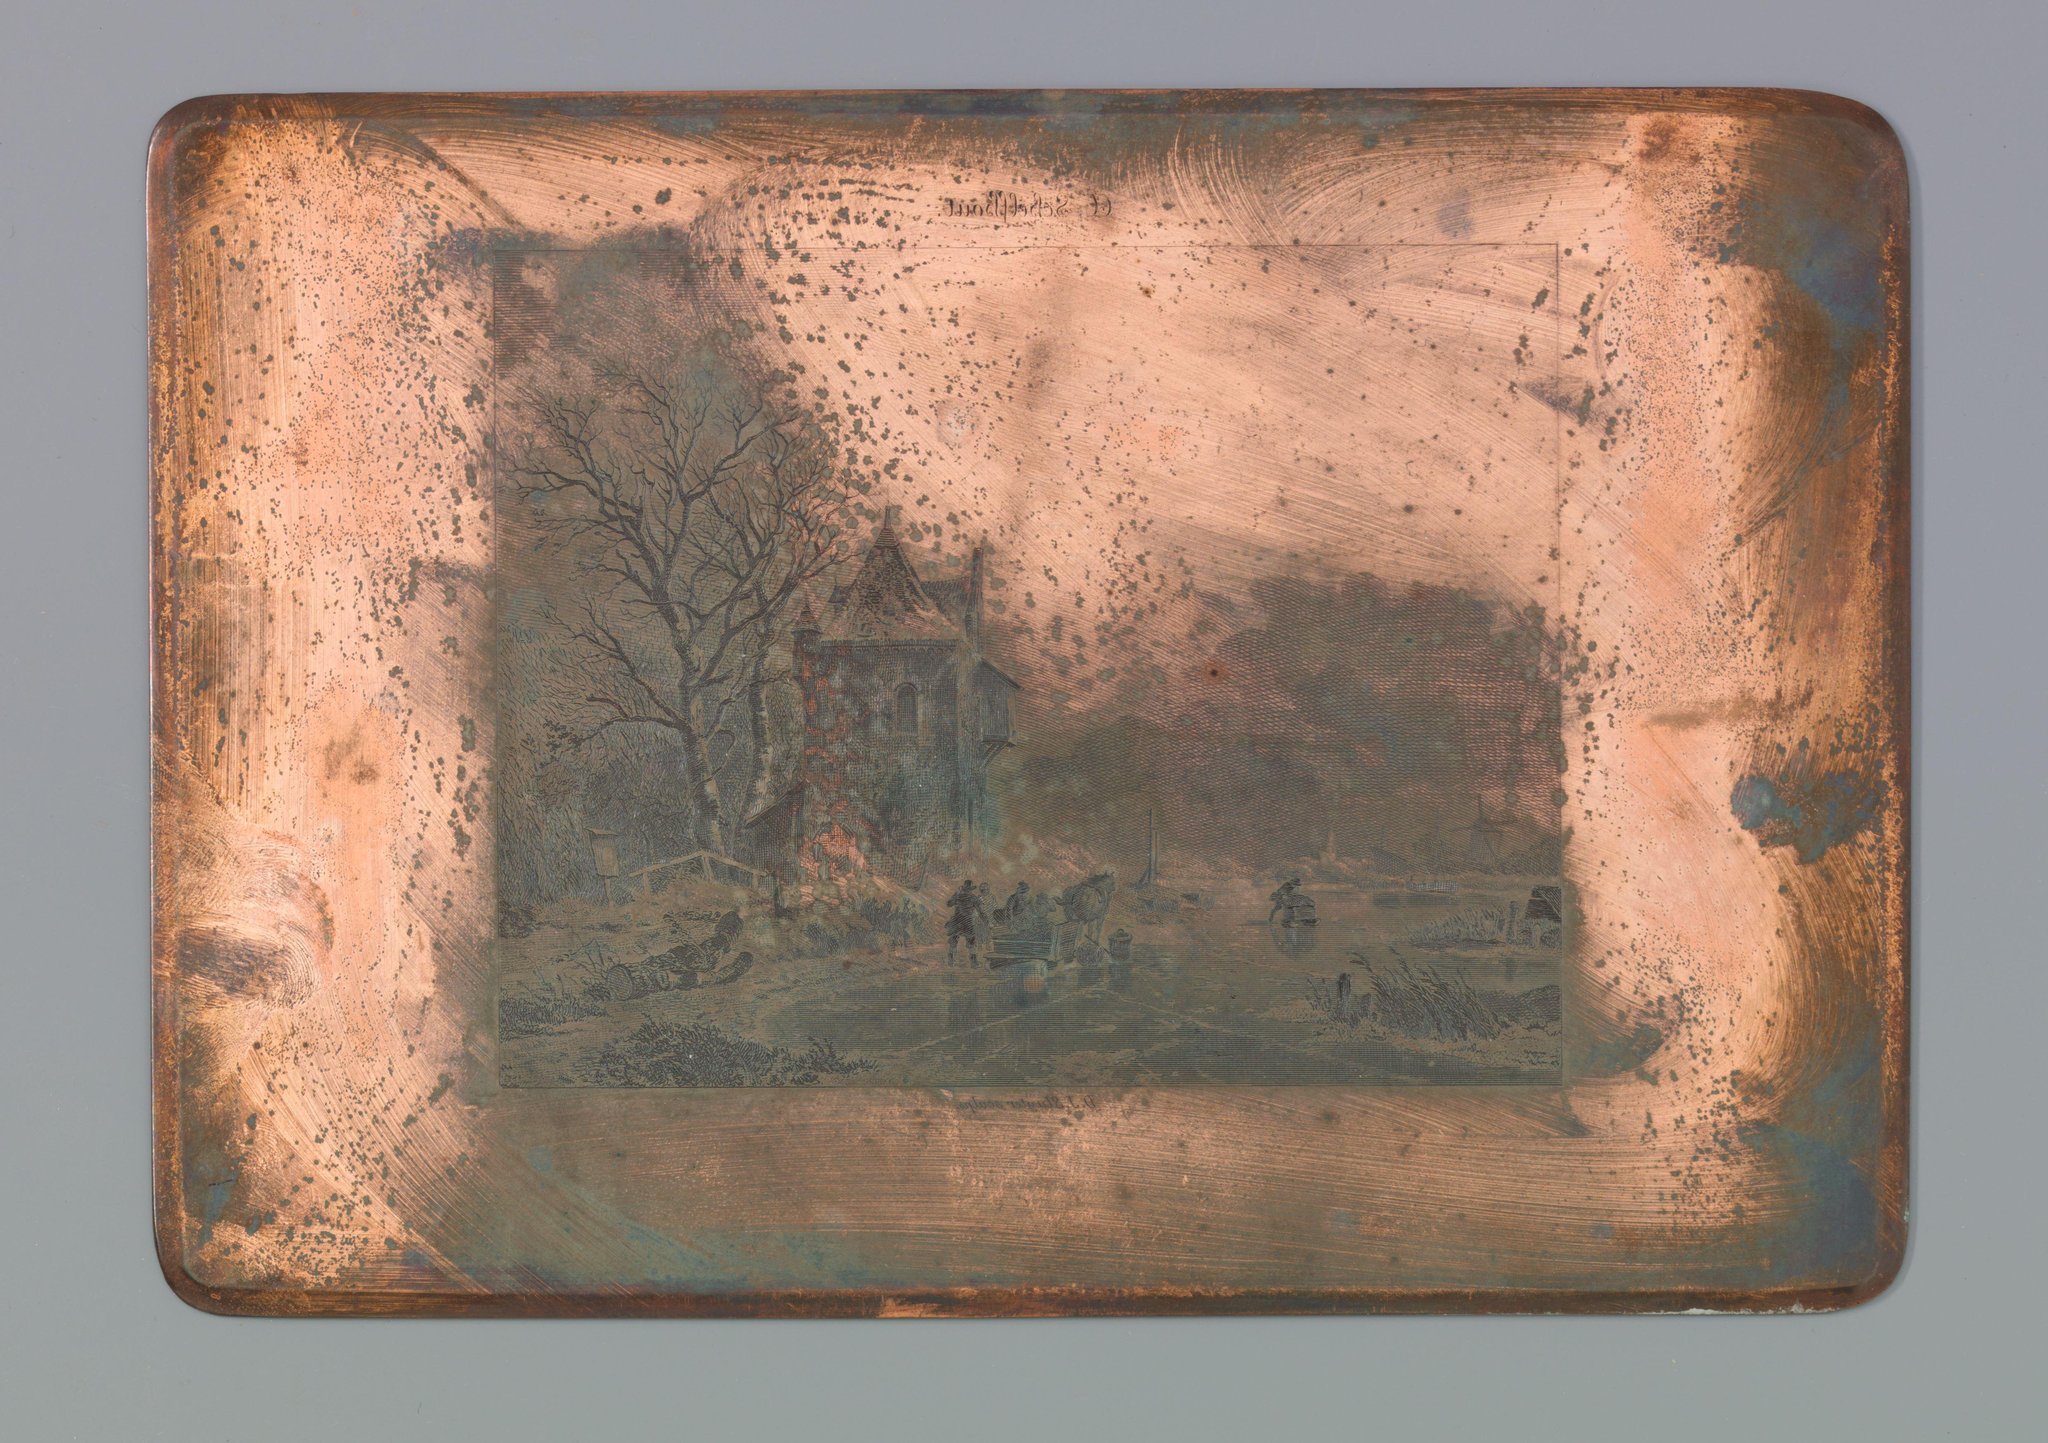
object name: copper plate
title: Winterlandschap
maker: dirk jurriaan sluyter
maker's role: draughtsman, print maker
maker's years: 1811-1886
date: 1821-1886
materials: copper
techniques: etching